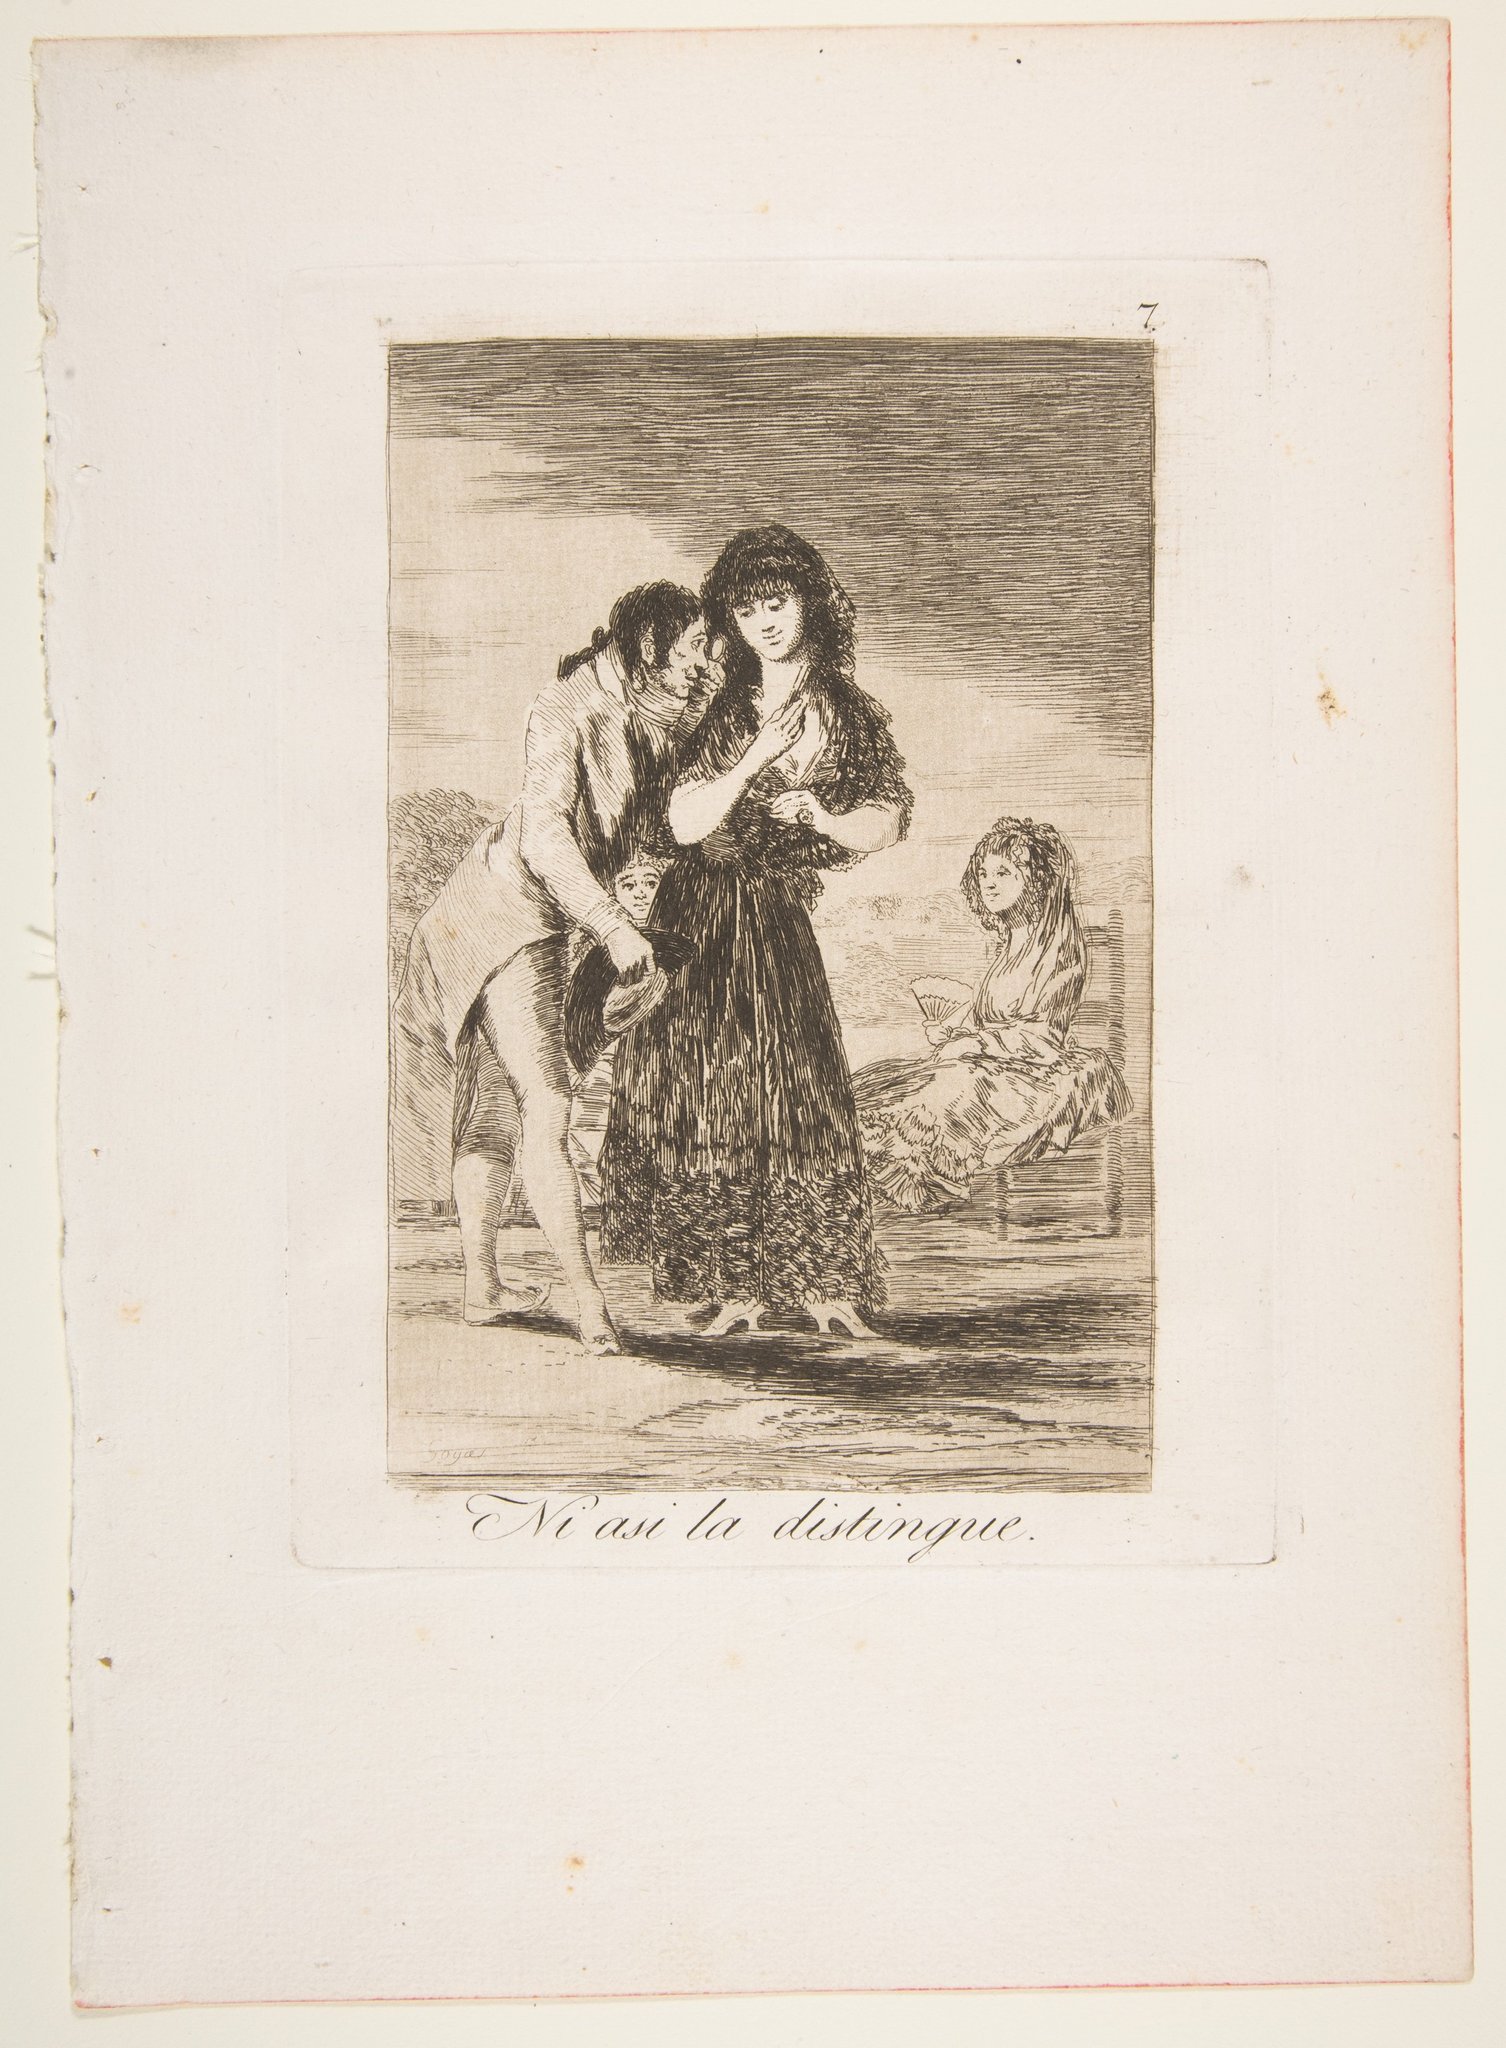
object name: print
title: Plate 7 from "Los Caprichos": Even thus he cannot make her out (Ni asi la distingue)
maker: goya (francisco de goya y lucientes)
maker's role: artist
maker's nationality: spanish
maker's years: 1746-1828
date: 1799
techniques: aquatint, drypoint, etching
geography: spain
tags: men,women,chairs